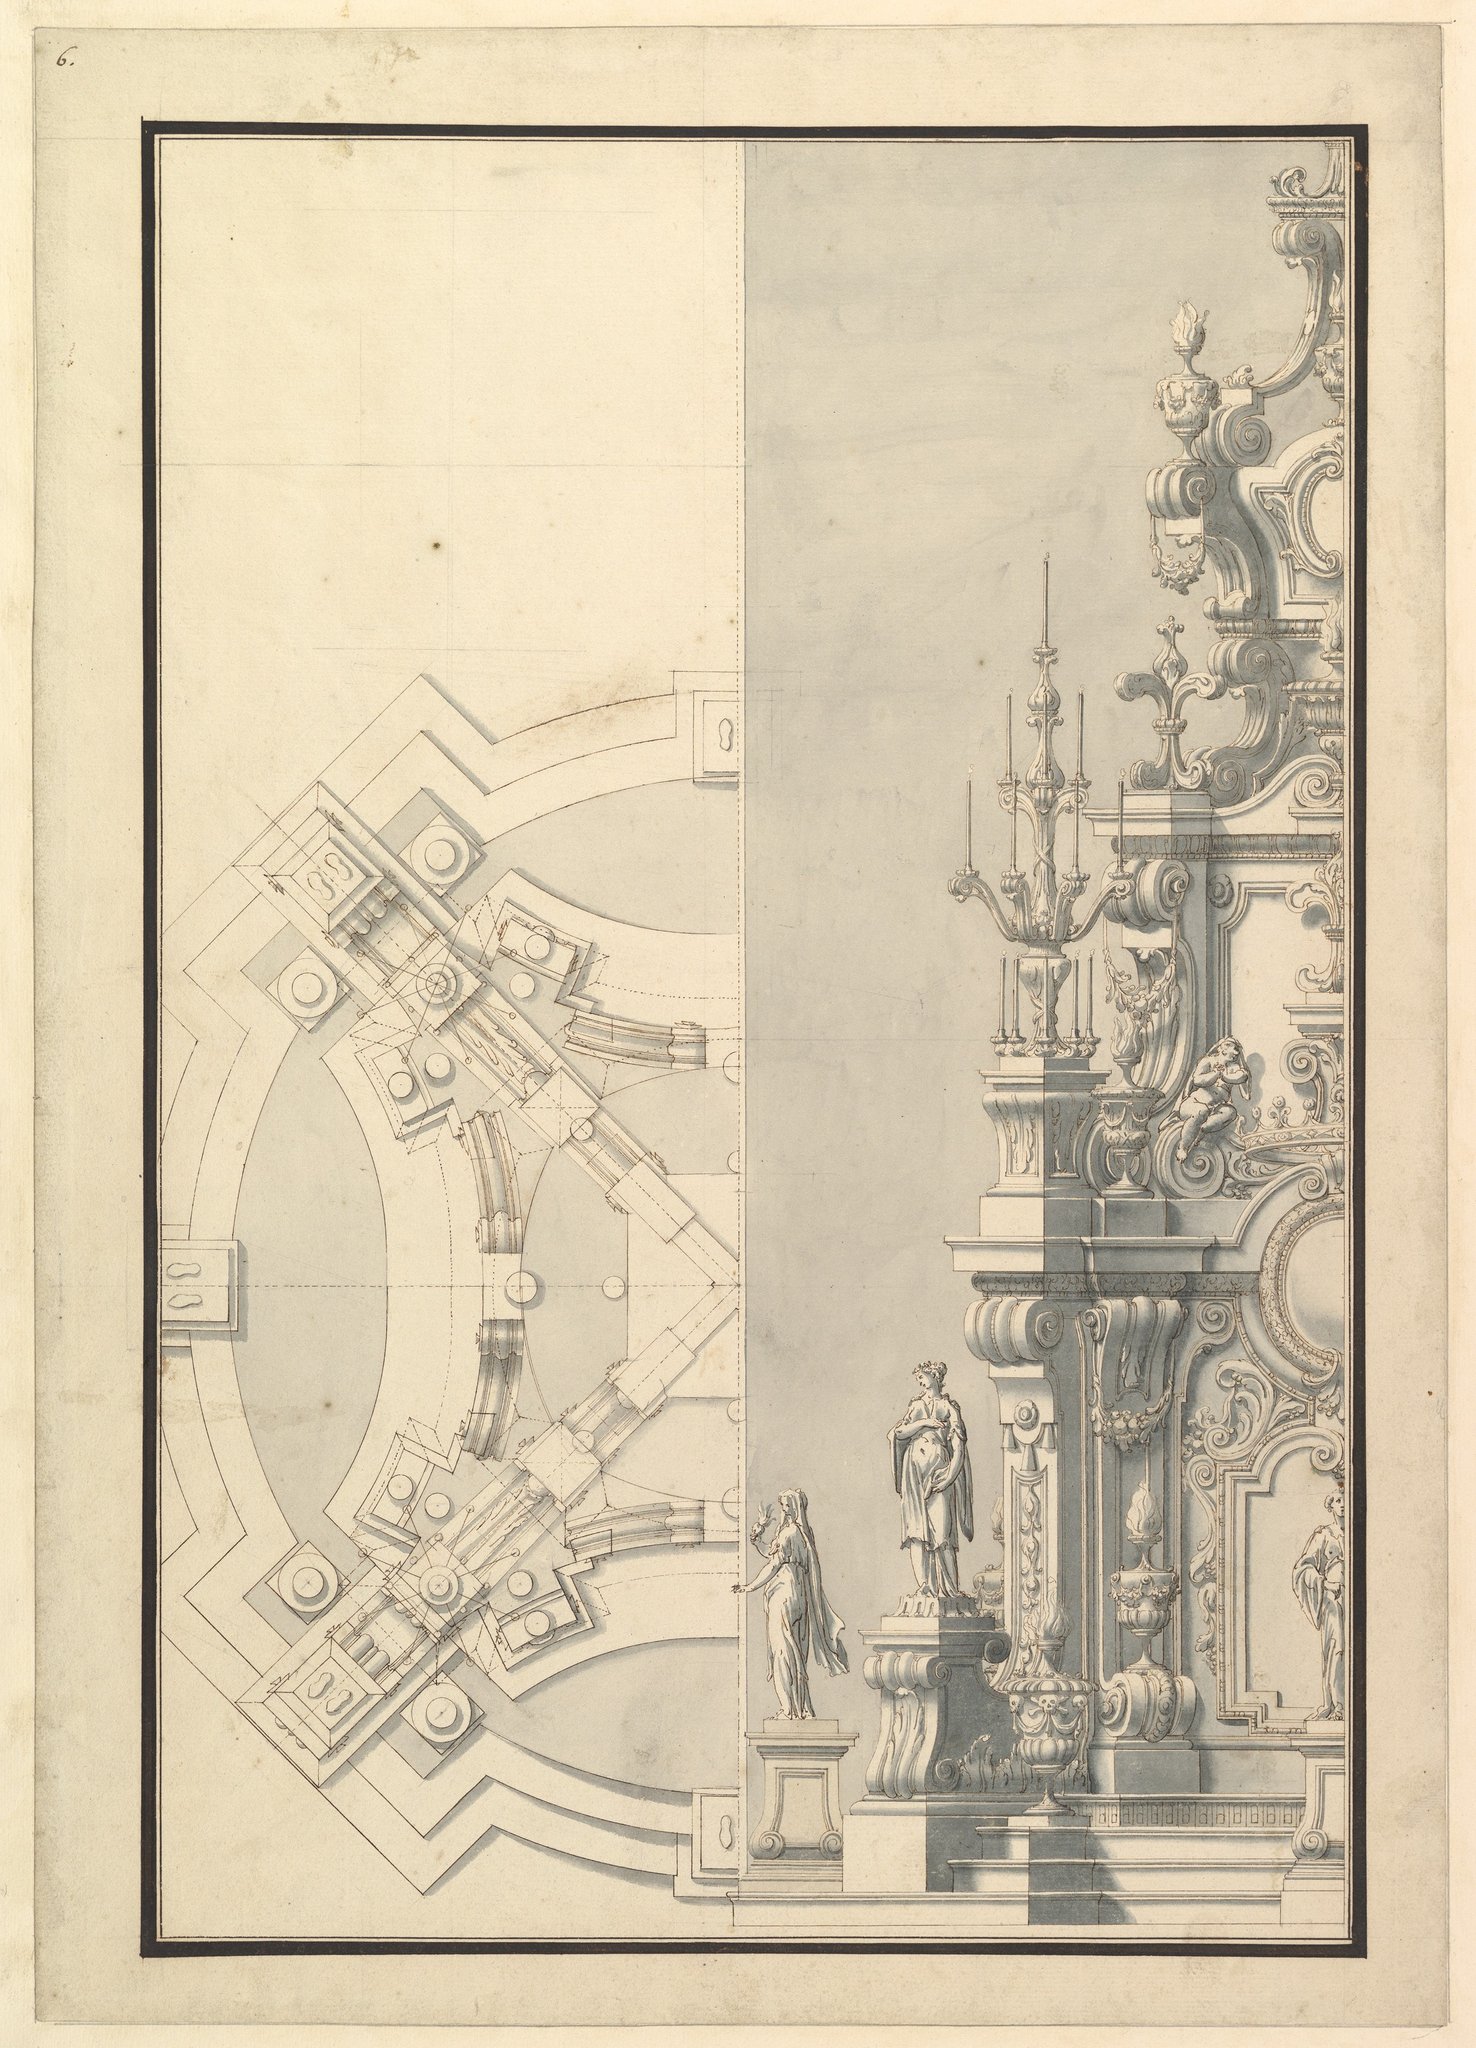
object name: drawing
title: Half Ground Plan and Half Elevation for a Catafalque for Duke Francesco of Parma (1694–1727)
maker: giuseppe galli bibiena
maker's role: artist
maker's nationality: italian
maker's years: 1696-1756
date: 1727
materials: ink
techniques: pen, wash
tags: architecture